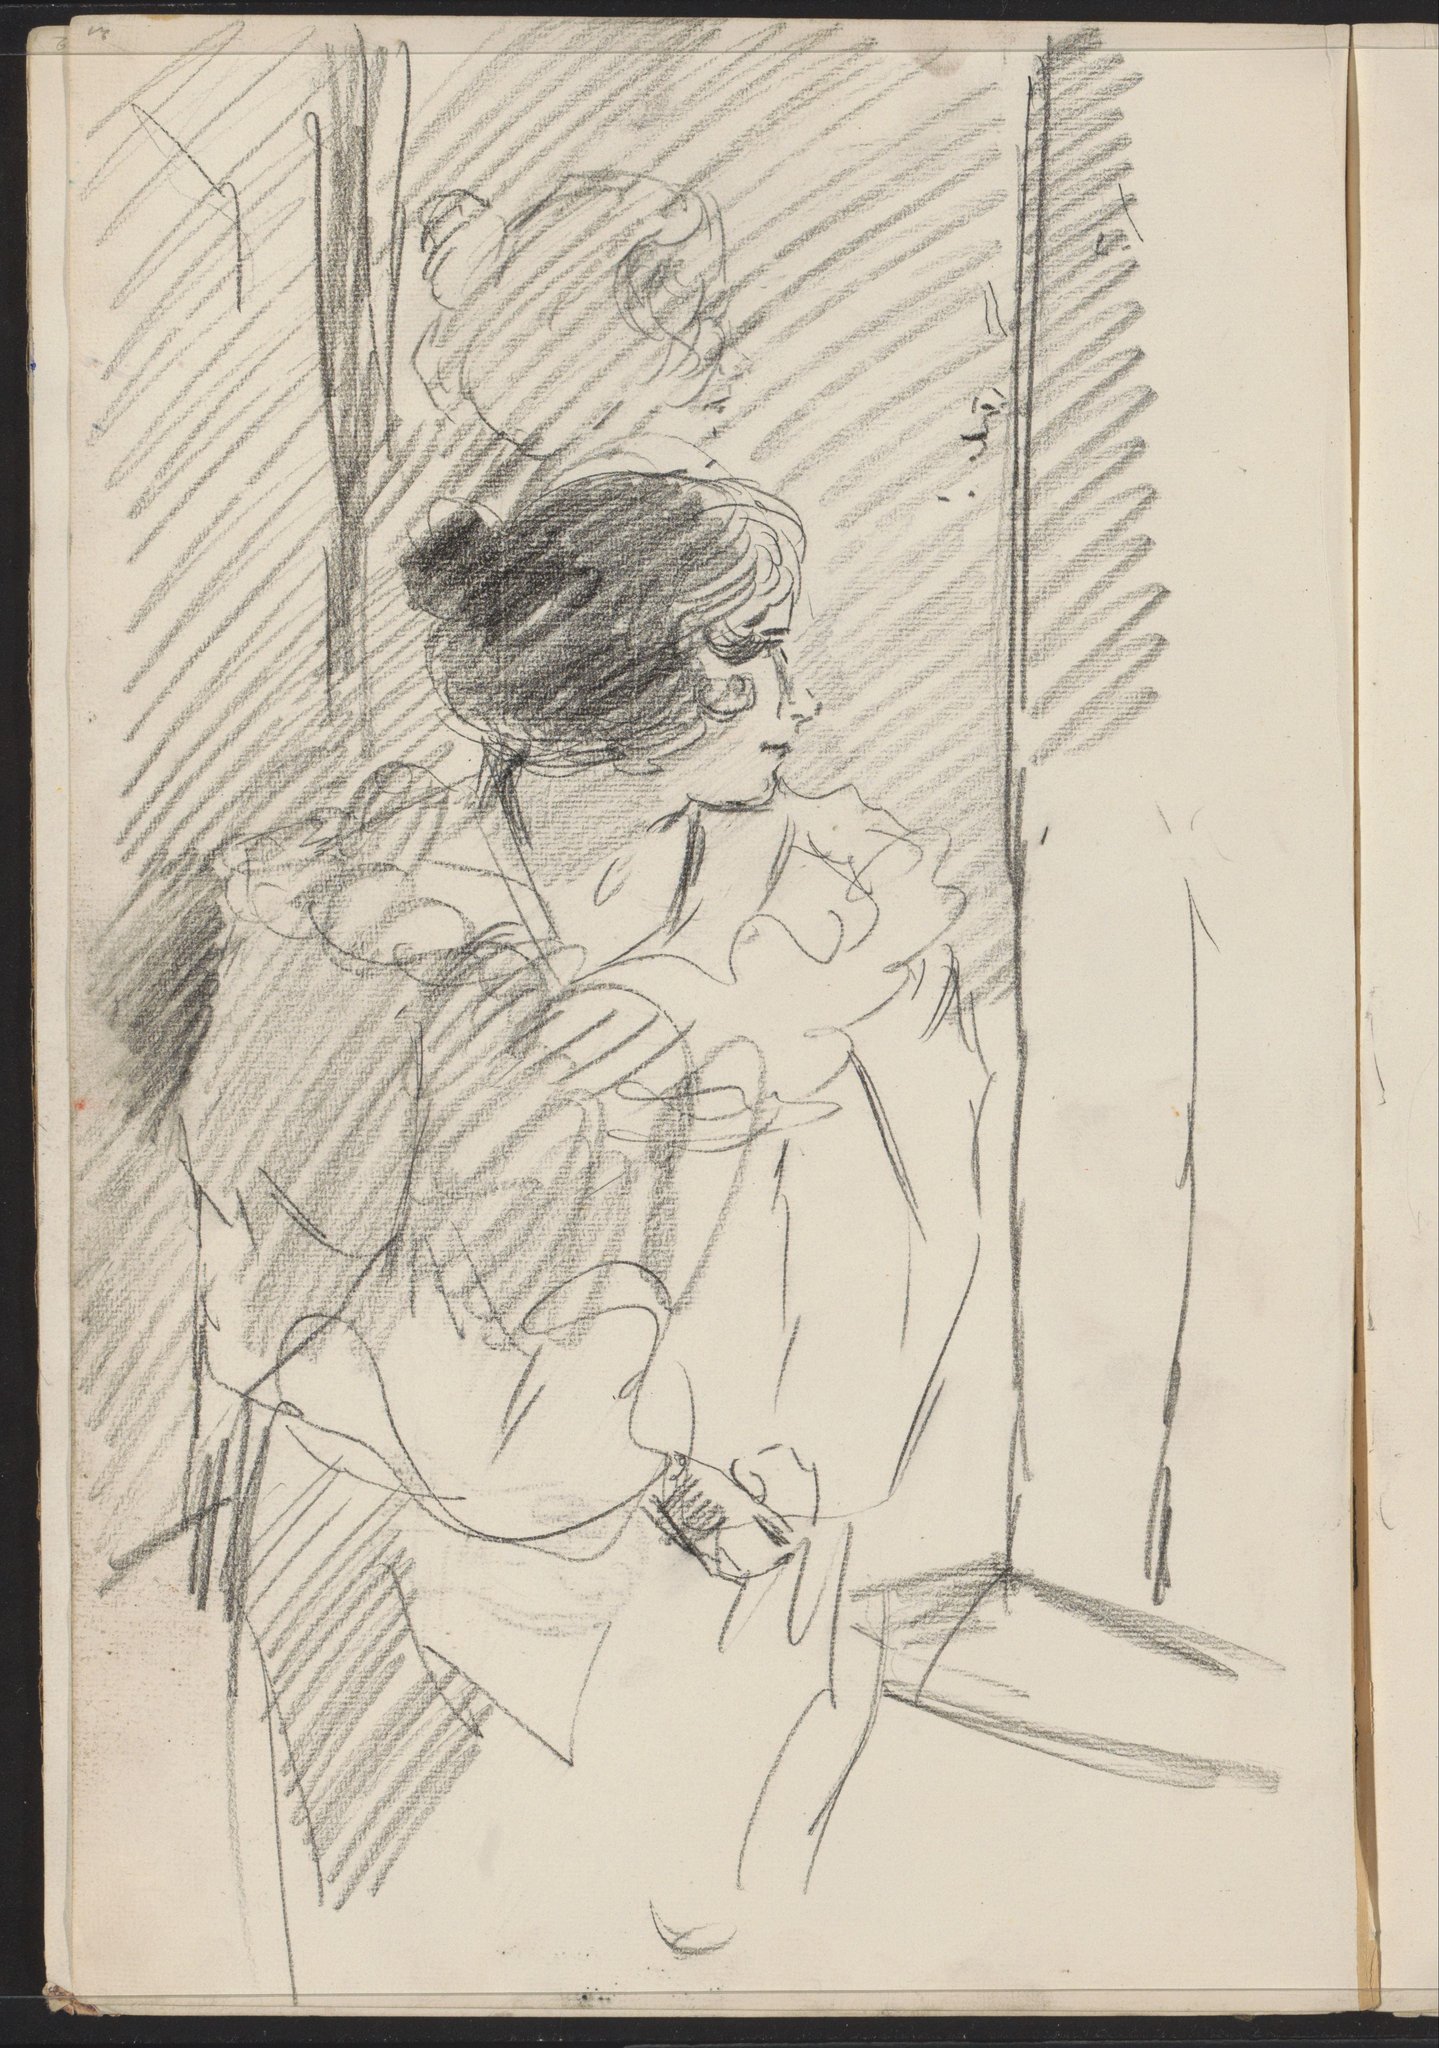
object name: sketchbook leaf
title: Zittende vrouw met hoofdtooi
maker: isaac israels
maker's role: draughtsman, painter, print maker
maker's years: 1865-1934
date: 1875-1934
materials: chalk, paper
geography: the hague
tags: head-gear, adult woman (+ standing)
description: Blad 2 verso uit schetsboek LXVIII met 11 bladen.